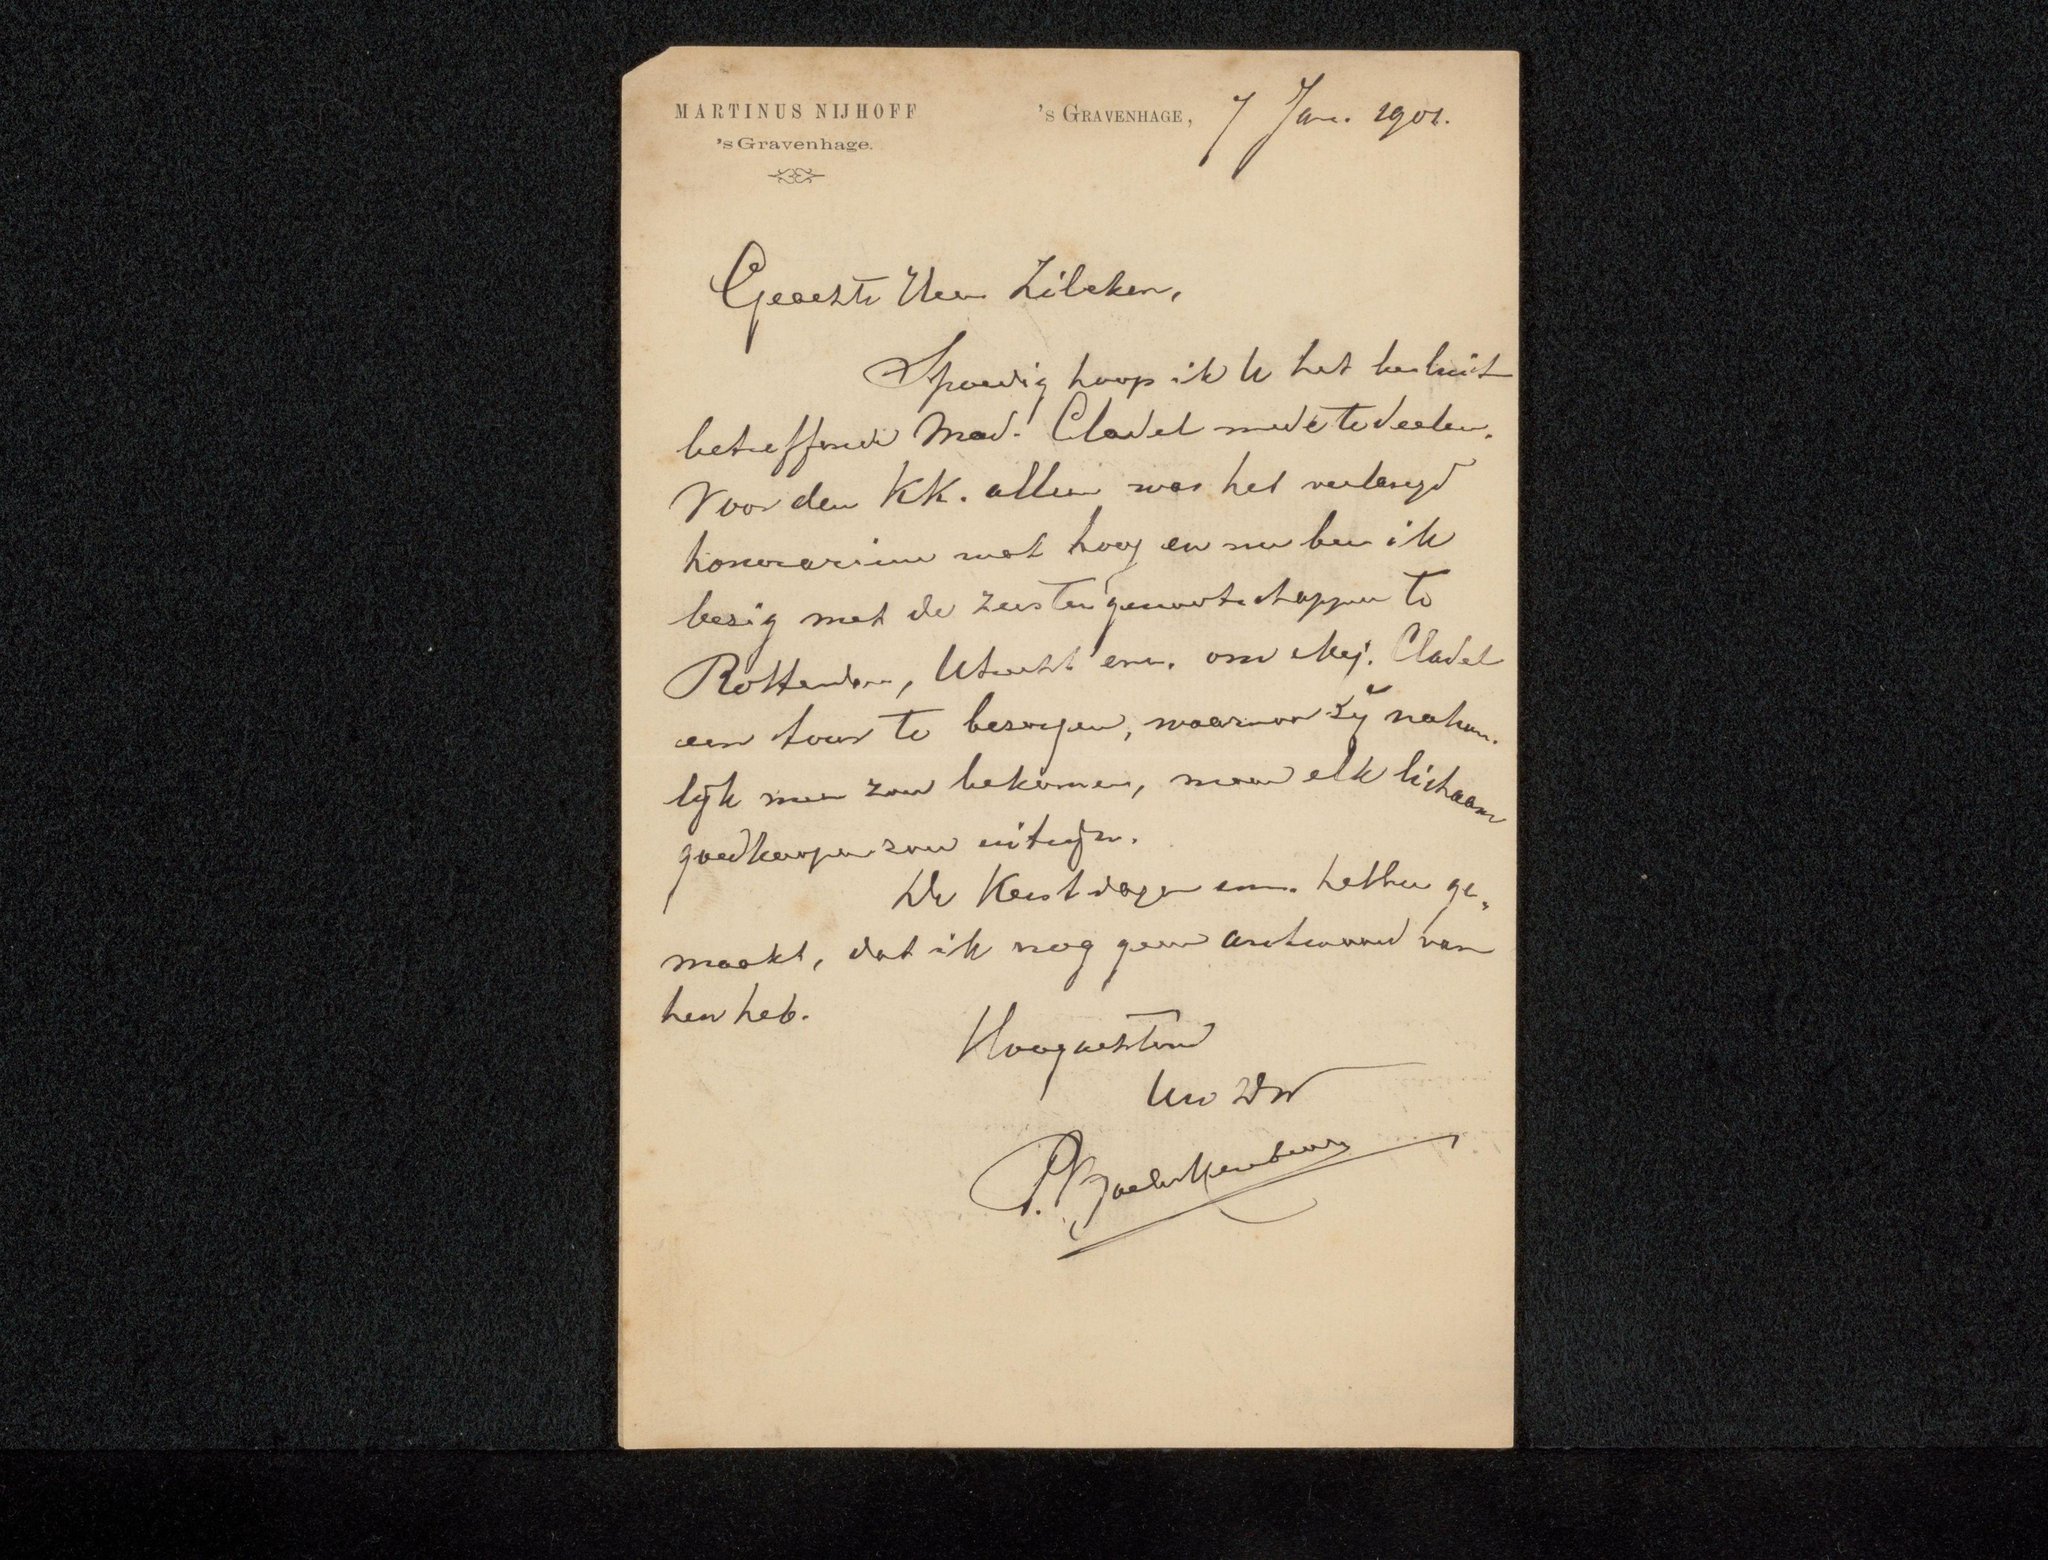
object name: letter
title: Brief aan Philip Zilcken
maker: pieter andreas martin boele van hensbroek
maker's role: publisher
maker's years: 1853-1912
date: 1901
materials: ink, paper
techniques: pen, printing, writing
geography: the hague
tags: painter, draughtsman, philip zilcken, rotterdam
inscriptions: collector's mark: ‘RPK’, address: ‘MARTINUS NIJHOFF 'S-GRAVENHAGE’